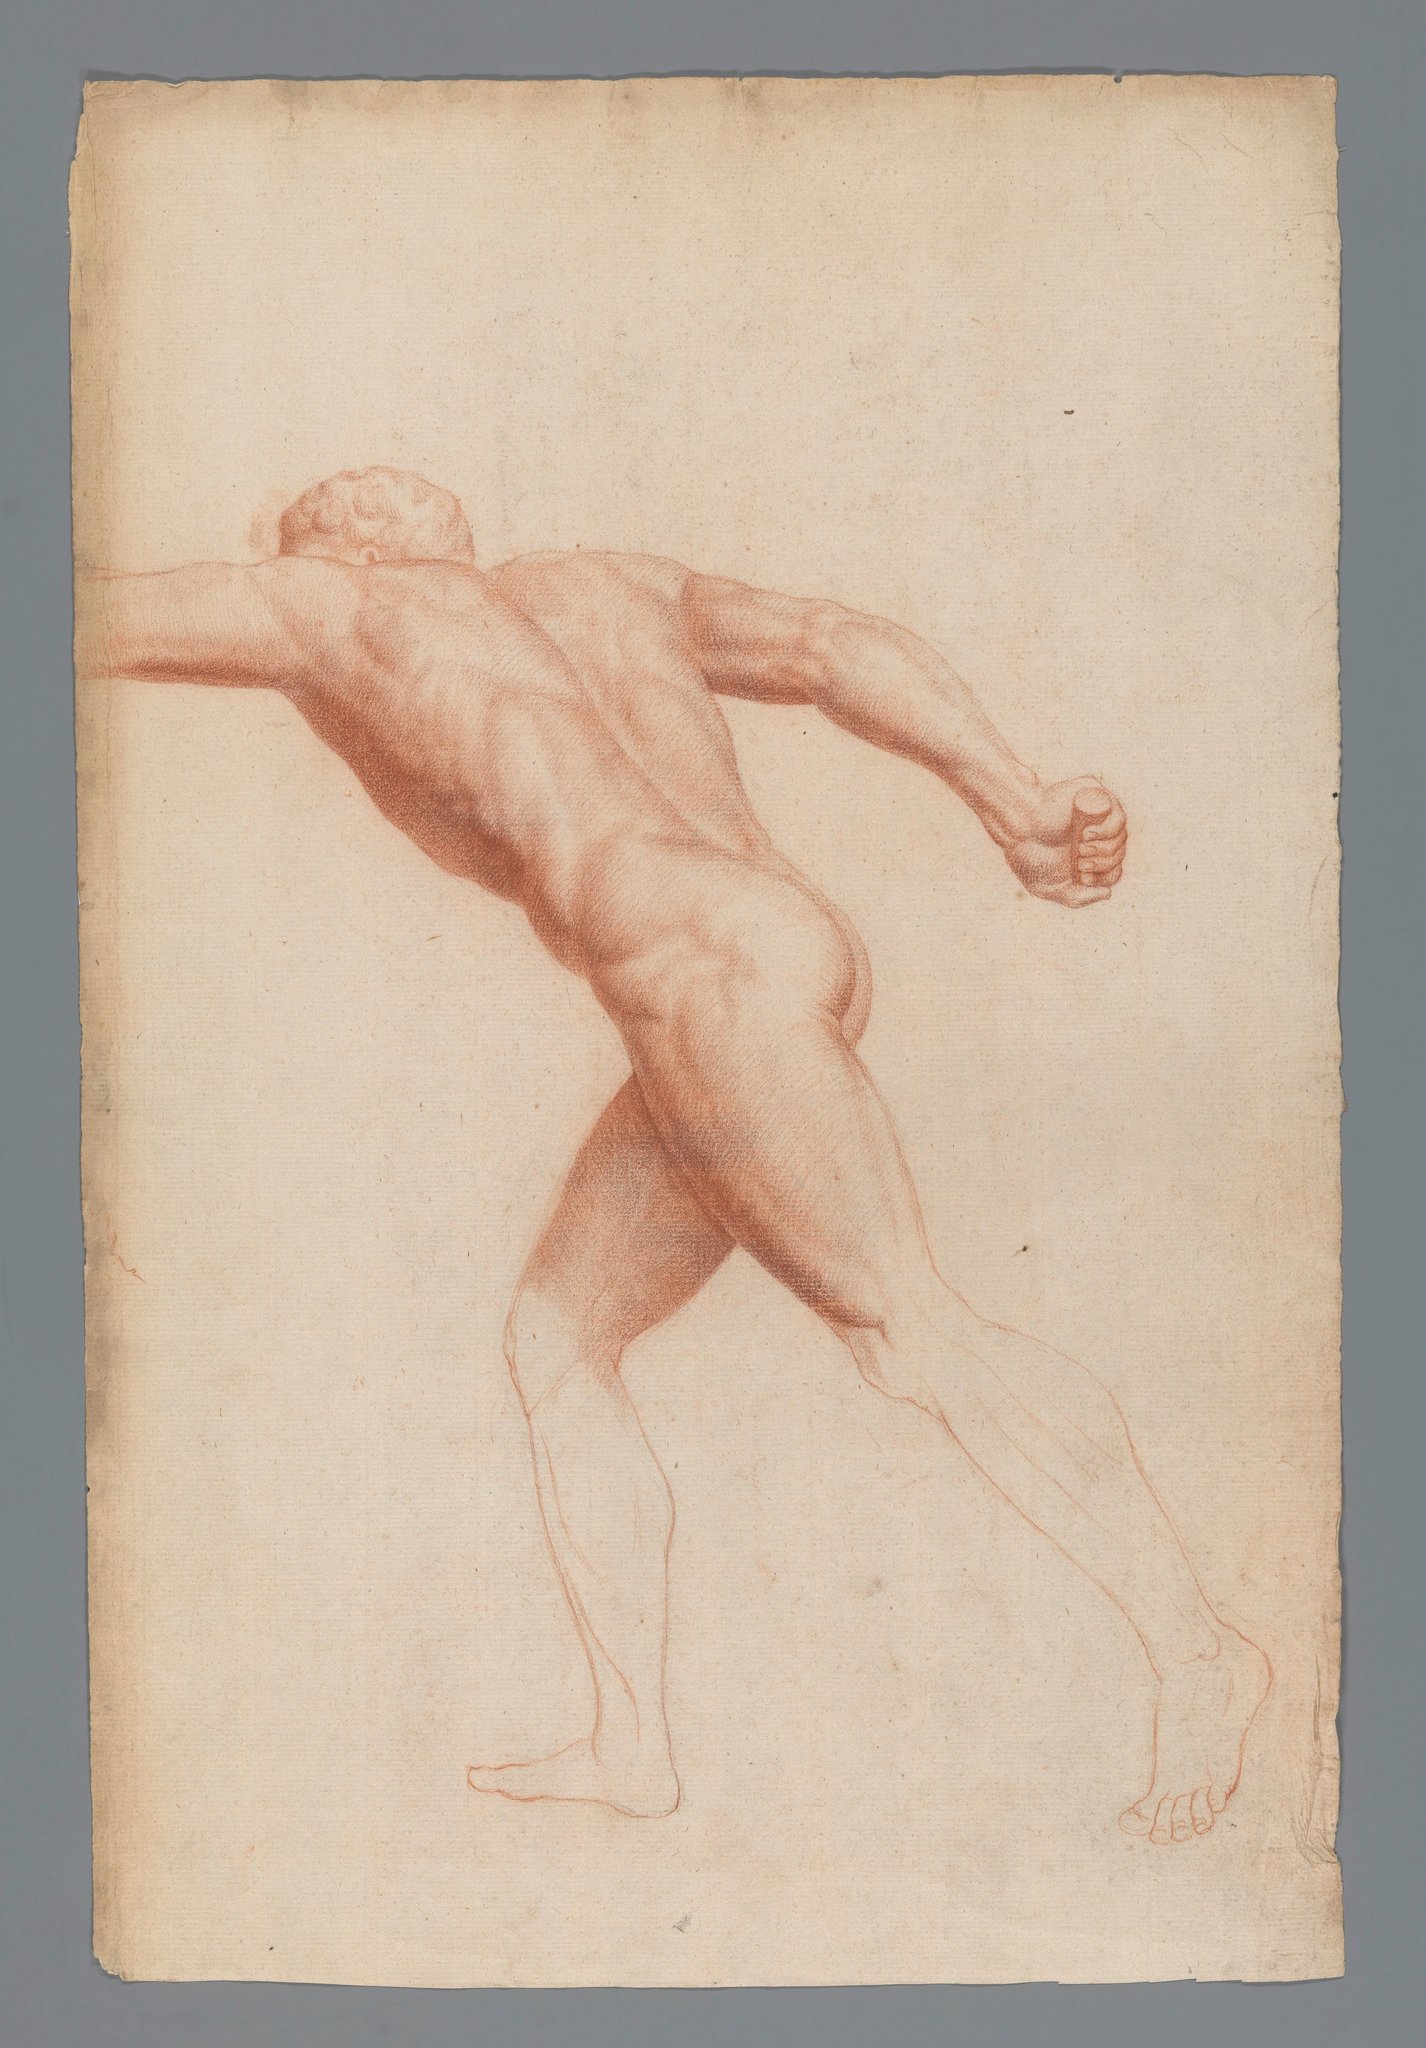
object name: drawing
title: Studie naar beeld van atleet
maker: alexander cranendoncq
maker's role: draughtsman, print maker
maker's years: 1799-1869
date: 1809-1869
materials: chalk, paper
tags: piece of sculpture, reproduction of a piece of sculpture